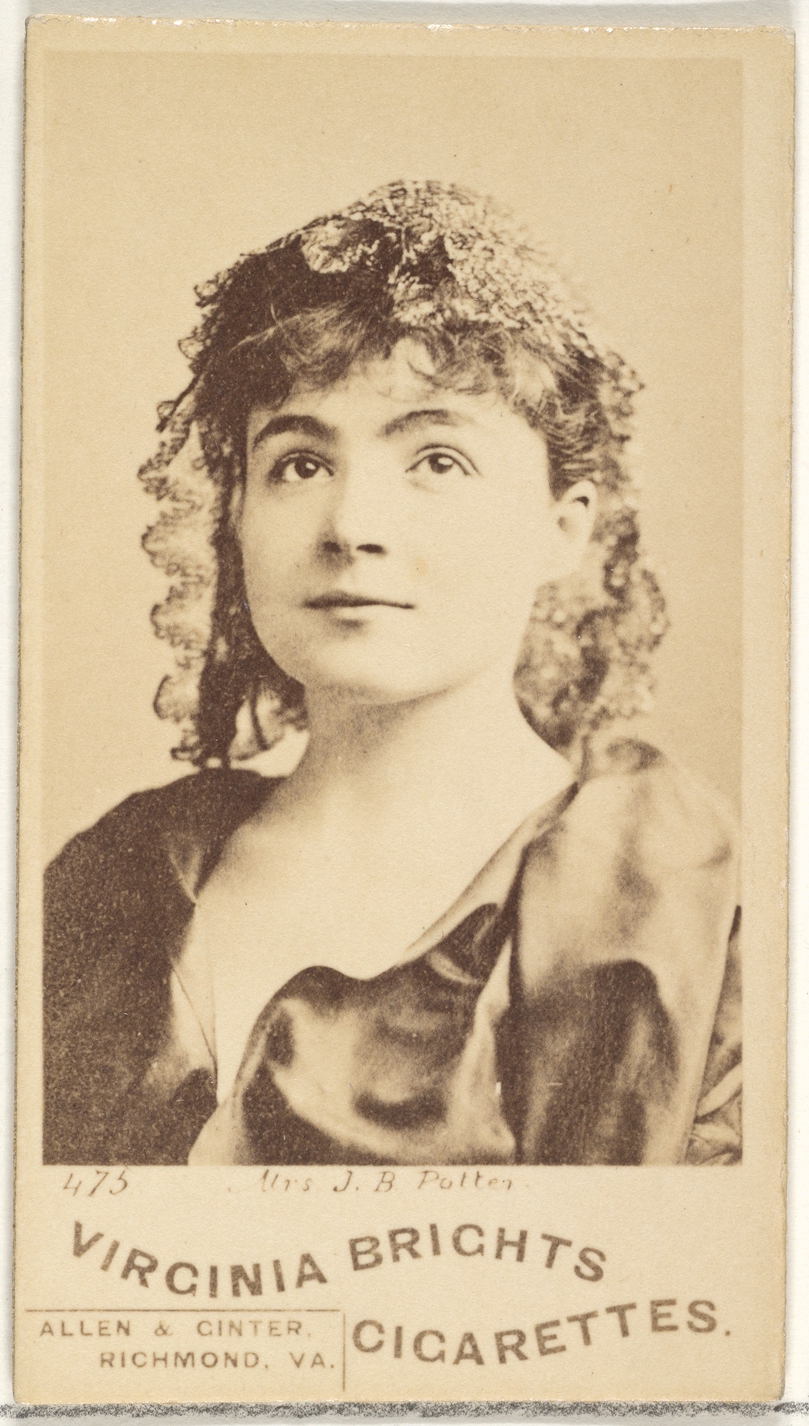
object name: photograph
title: Card 475, Mrs. J.B. Potter, from the Actors and Actresses series (N45, Type 1) for Virginia Brights Cigarettes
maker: allen & ginter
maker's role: publisher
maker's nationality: american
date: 1888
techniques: albumen silver print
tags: portraits,women,actresses